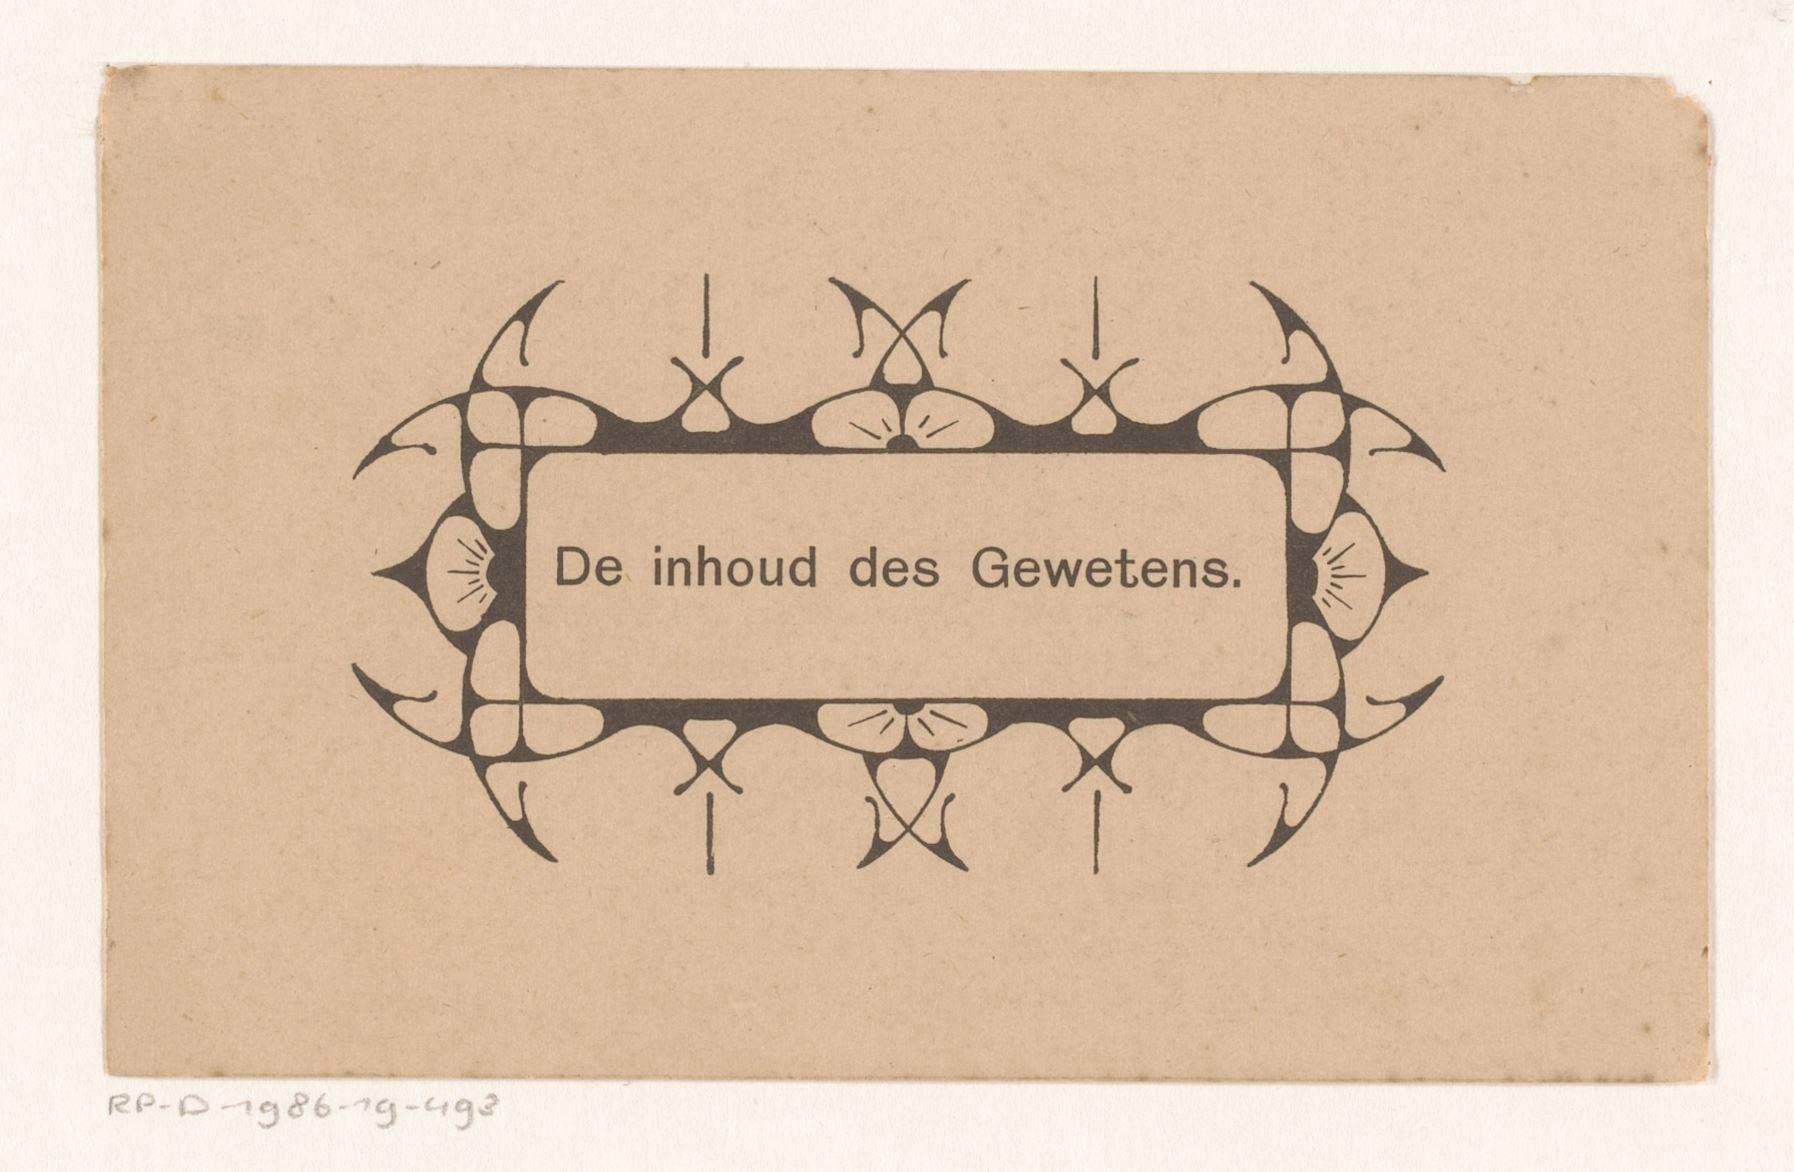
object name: photomechanical print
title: Hoofdstukkader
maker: reinier willem petrus de vries (1874-1953)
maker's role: draughtsman, print maker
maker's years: 1874-1953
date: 1899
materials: paper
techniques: printing block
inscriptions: collector's mark: ‘R:MVS.’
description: Hoofdstukkader voor: Zaalberg, W. De rots waarop wij bouwen. Amsterdam: Van Holkema en Warendorf, 1899.